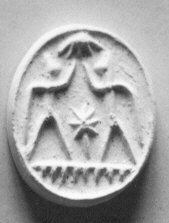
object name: stamp seal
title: Scarab seal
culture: cypriot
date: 700-501 BCE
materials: stone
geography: cyprus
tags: scarabs